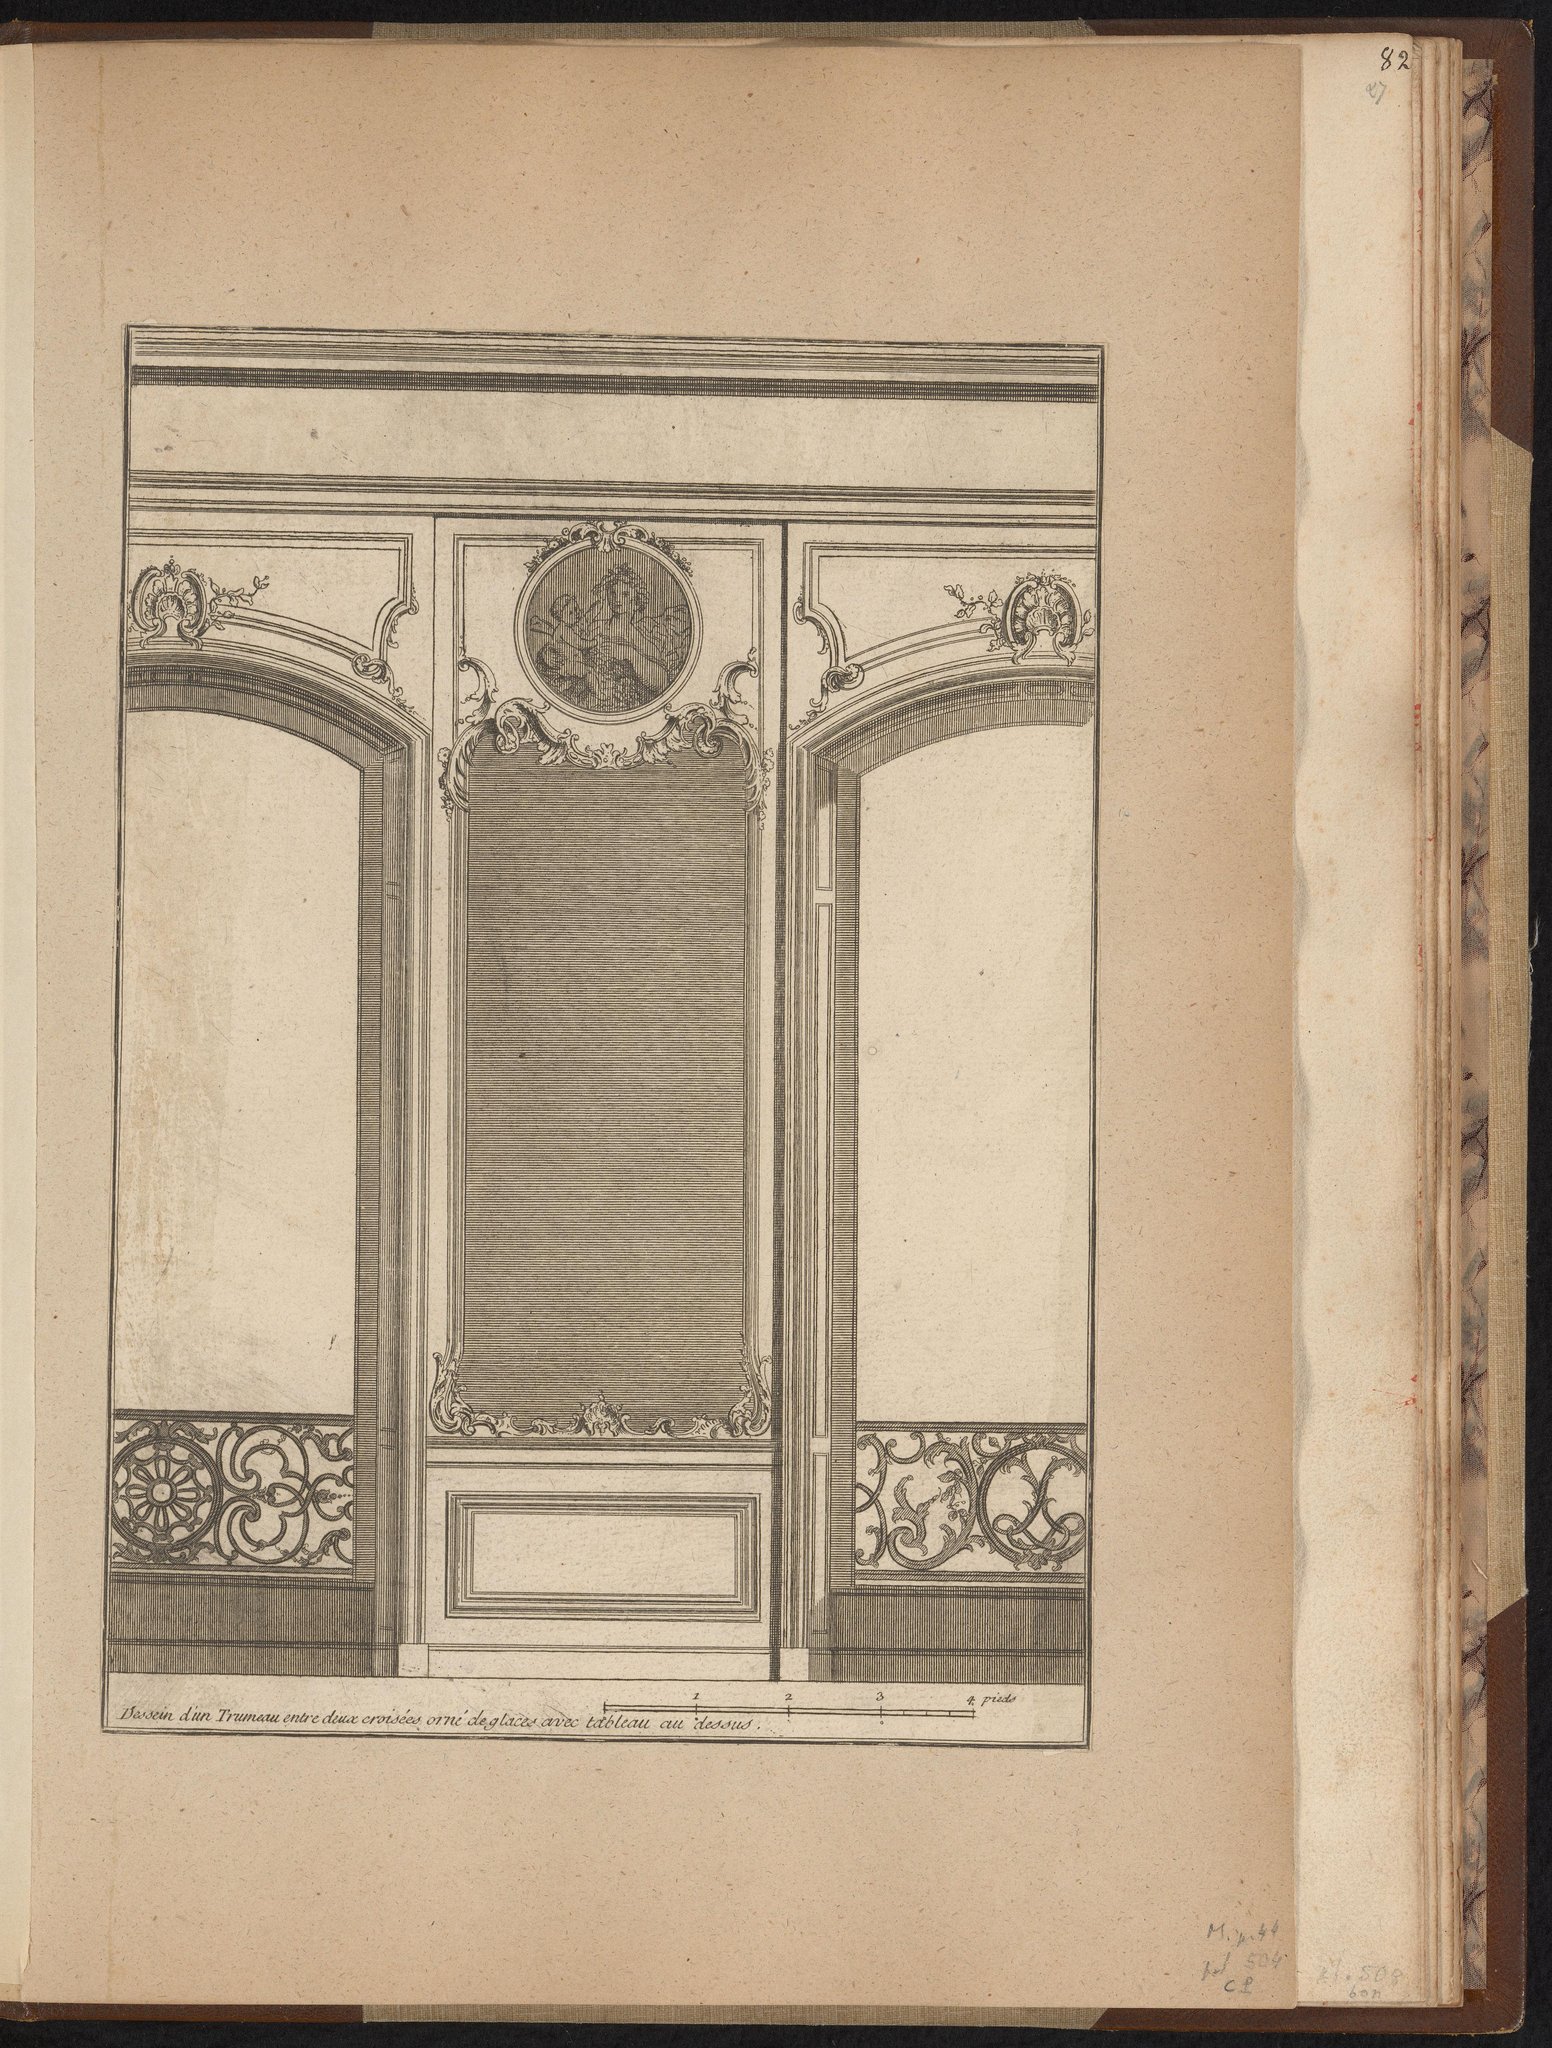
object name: print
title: Ontwerp voor een interieur met hoge spiegel met medaillon erboven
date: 1725-1750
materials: paper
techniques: etching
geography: paris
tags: ornamental cupboard, ornaments ~ art, bed, bedroom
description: Deze prent maakt deel uit van een album.